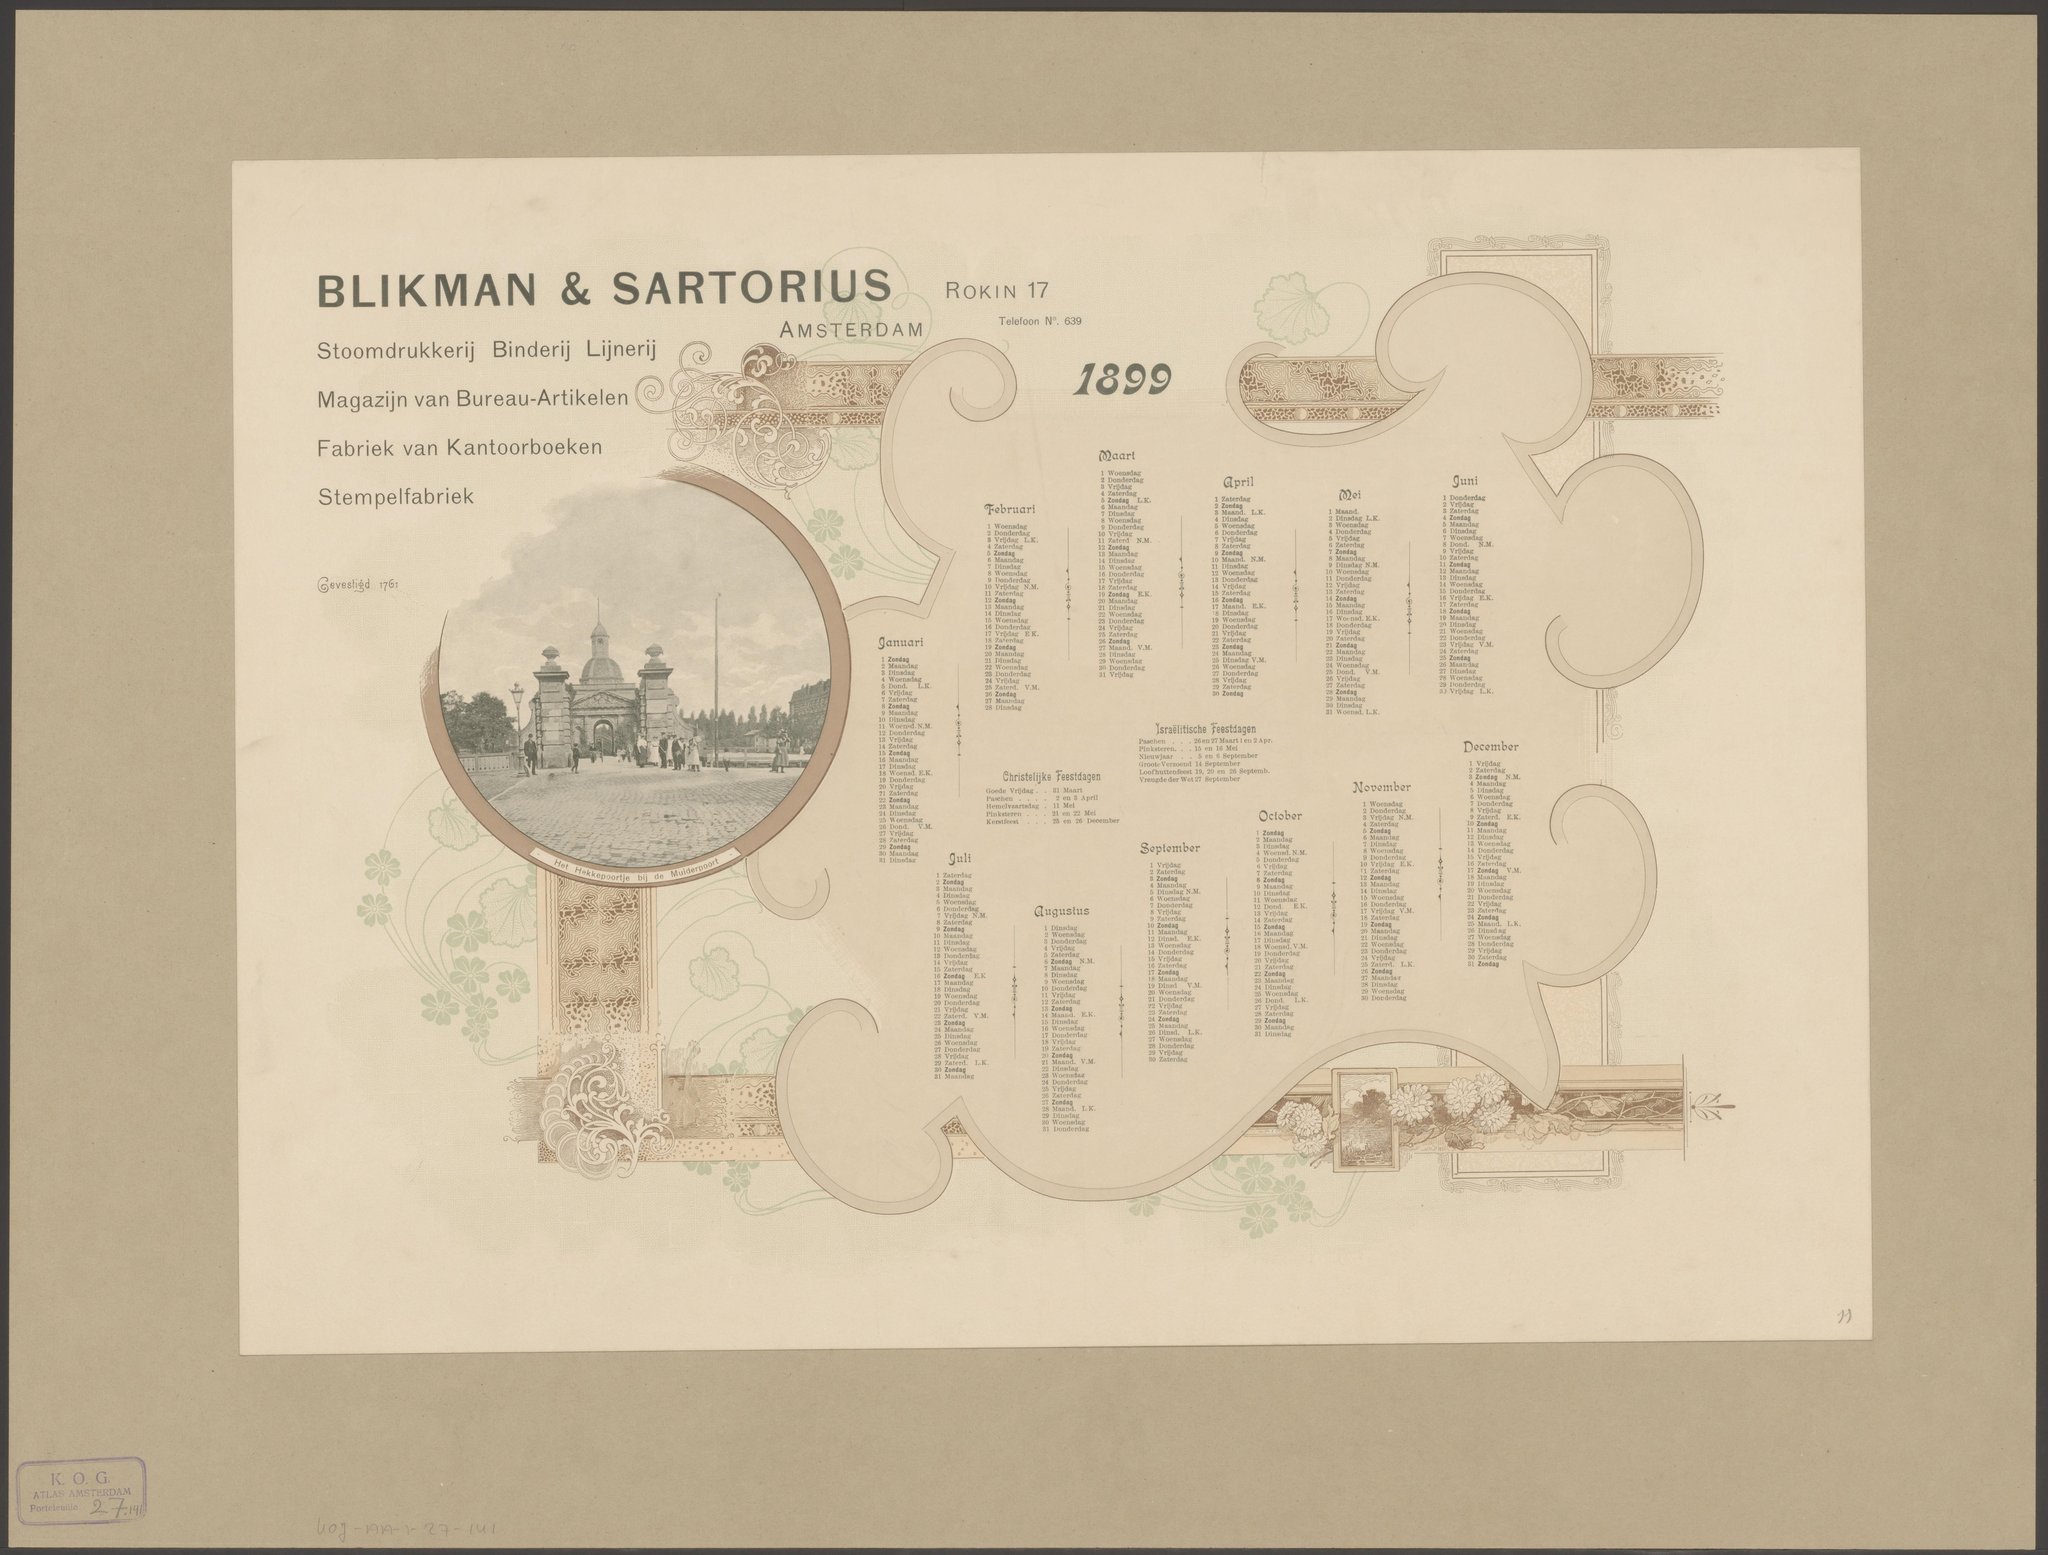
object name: calendar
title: Kalender met een gezicht op de Tweede Muiderpoort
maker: Anonymous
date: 1899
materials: paint, paper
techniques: line block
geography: amsterdam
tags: calendar, almanac, city-gate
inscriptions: collector's mark: Lugt 1641b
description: Kalender van de stoomboekdrukkerij en kantoorboekhandel Blikman & Sartorius te Amsterddam. Links een gezicht op het hek van de Tweede Muiderpoort. Onderwerpsrubriek binnen de Atlas Amsterdam: Poorten, verzamelbladen, J. Tweede Muiderpoort.